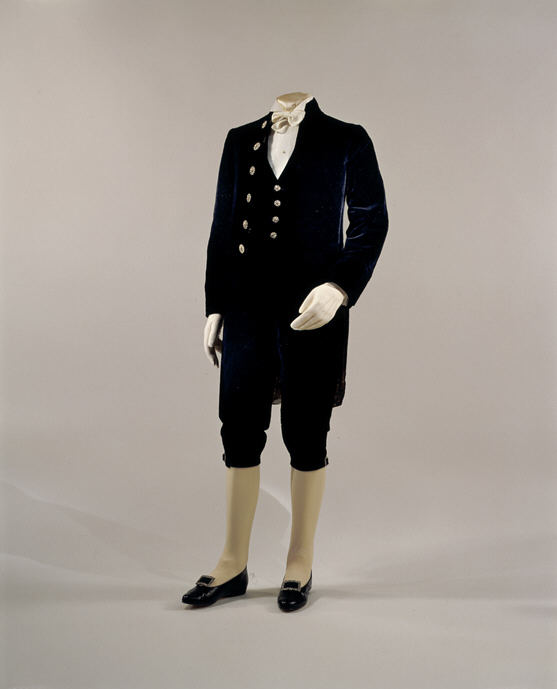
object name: court presentation suit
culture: british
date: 1877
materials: silk